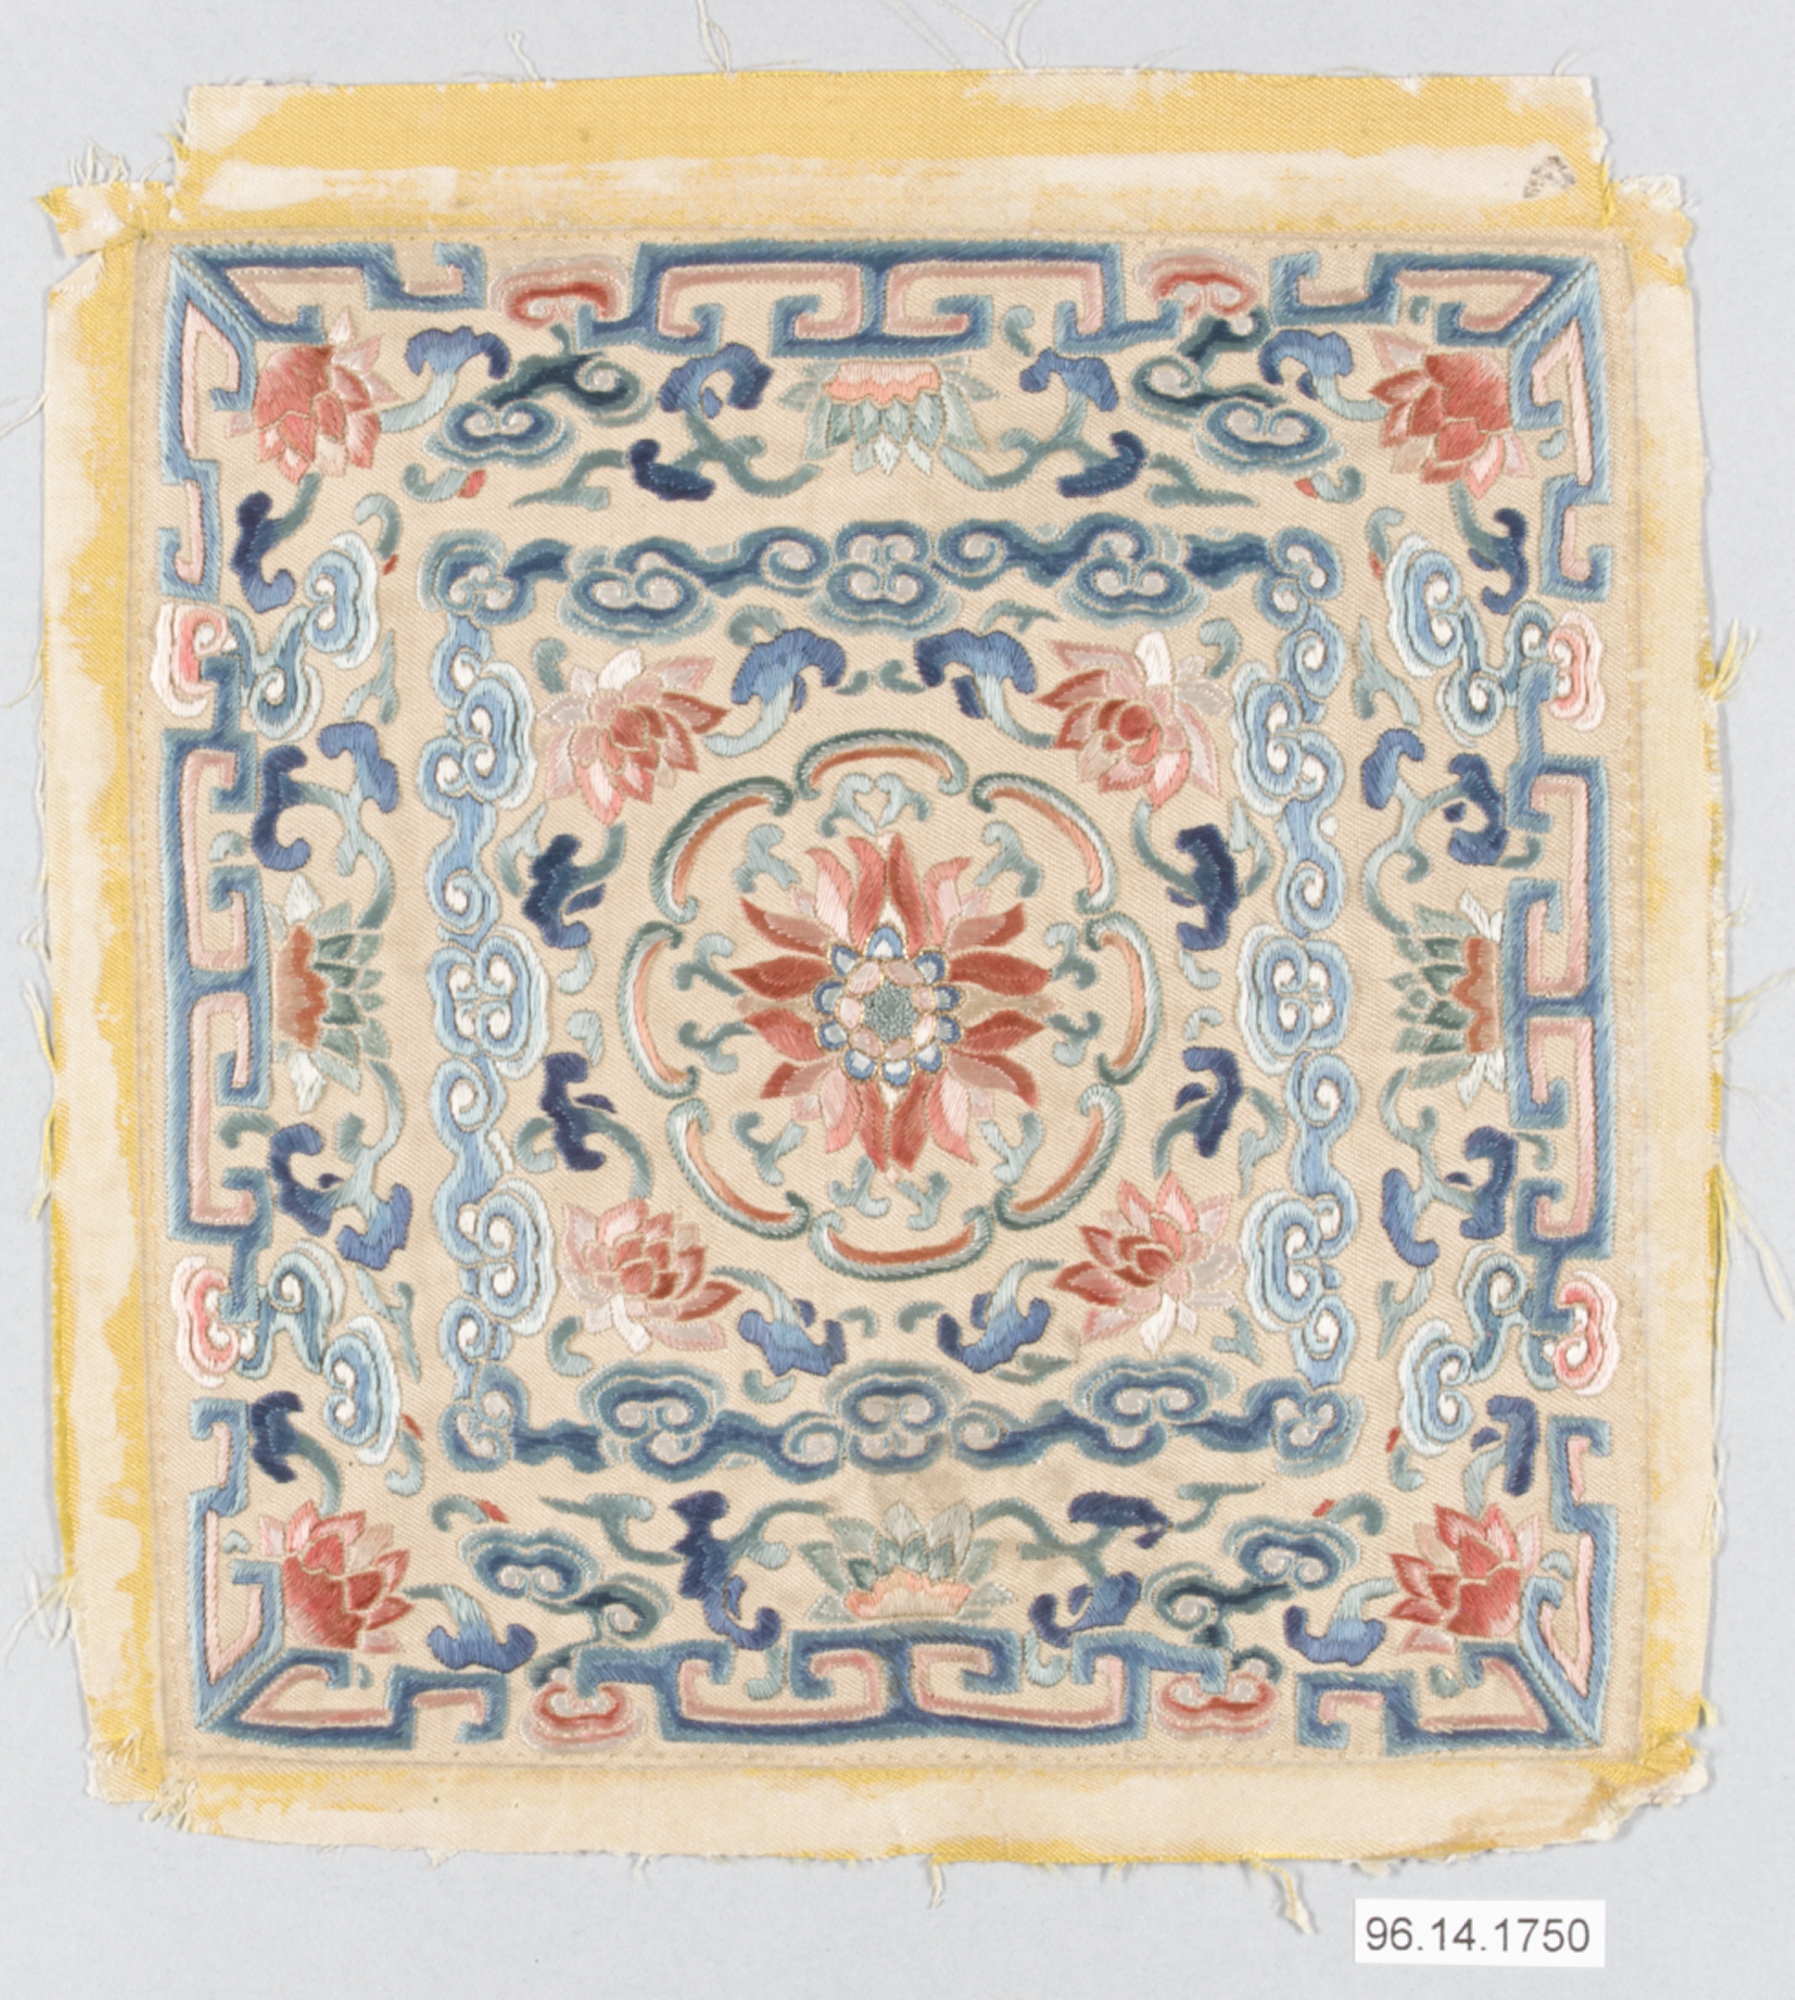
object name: panel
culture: chinese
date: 1701-1800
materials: metal thread, silk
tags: flowers